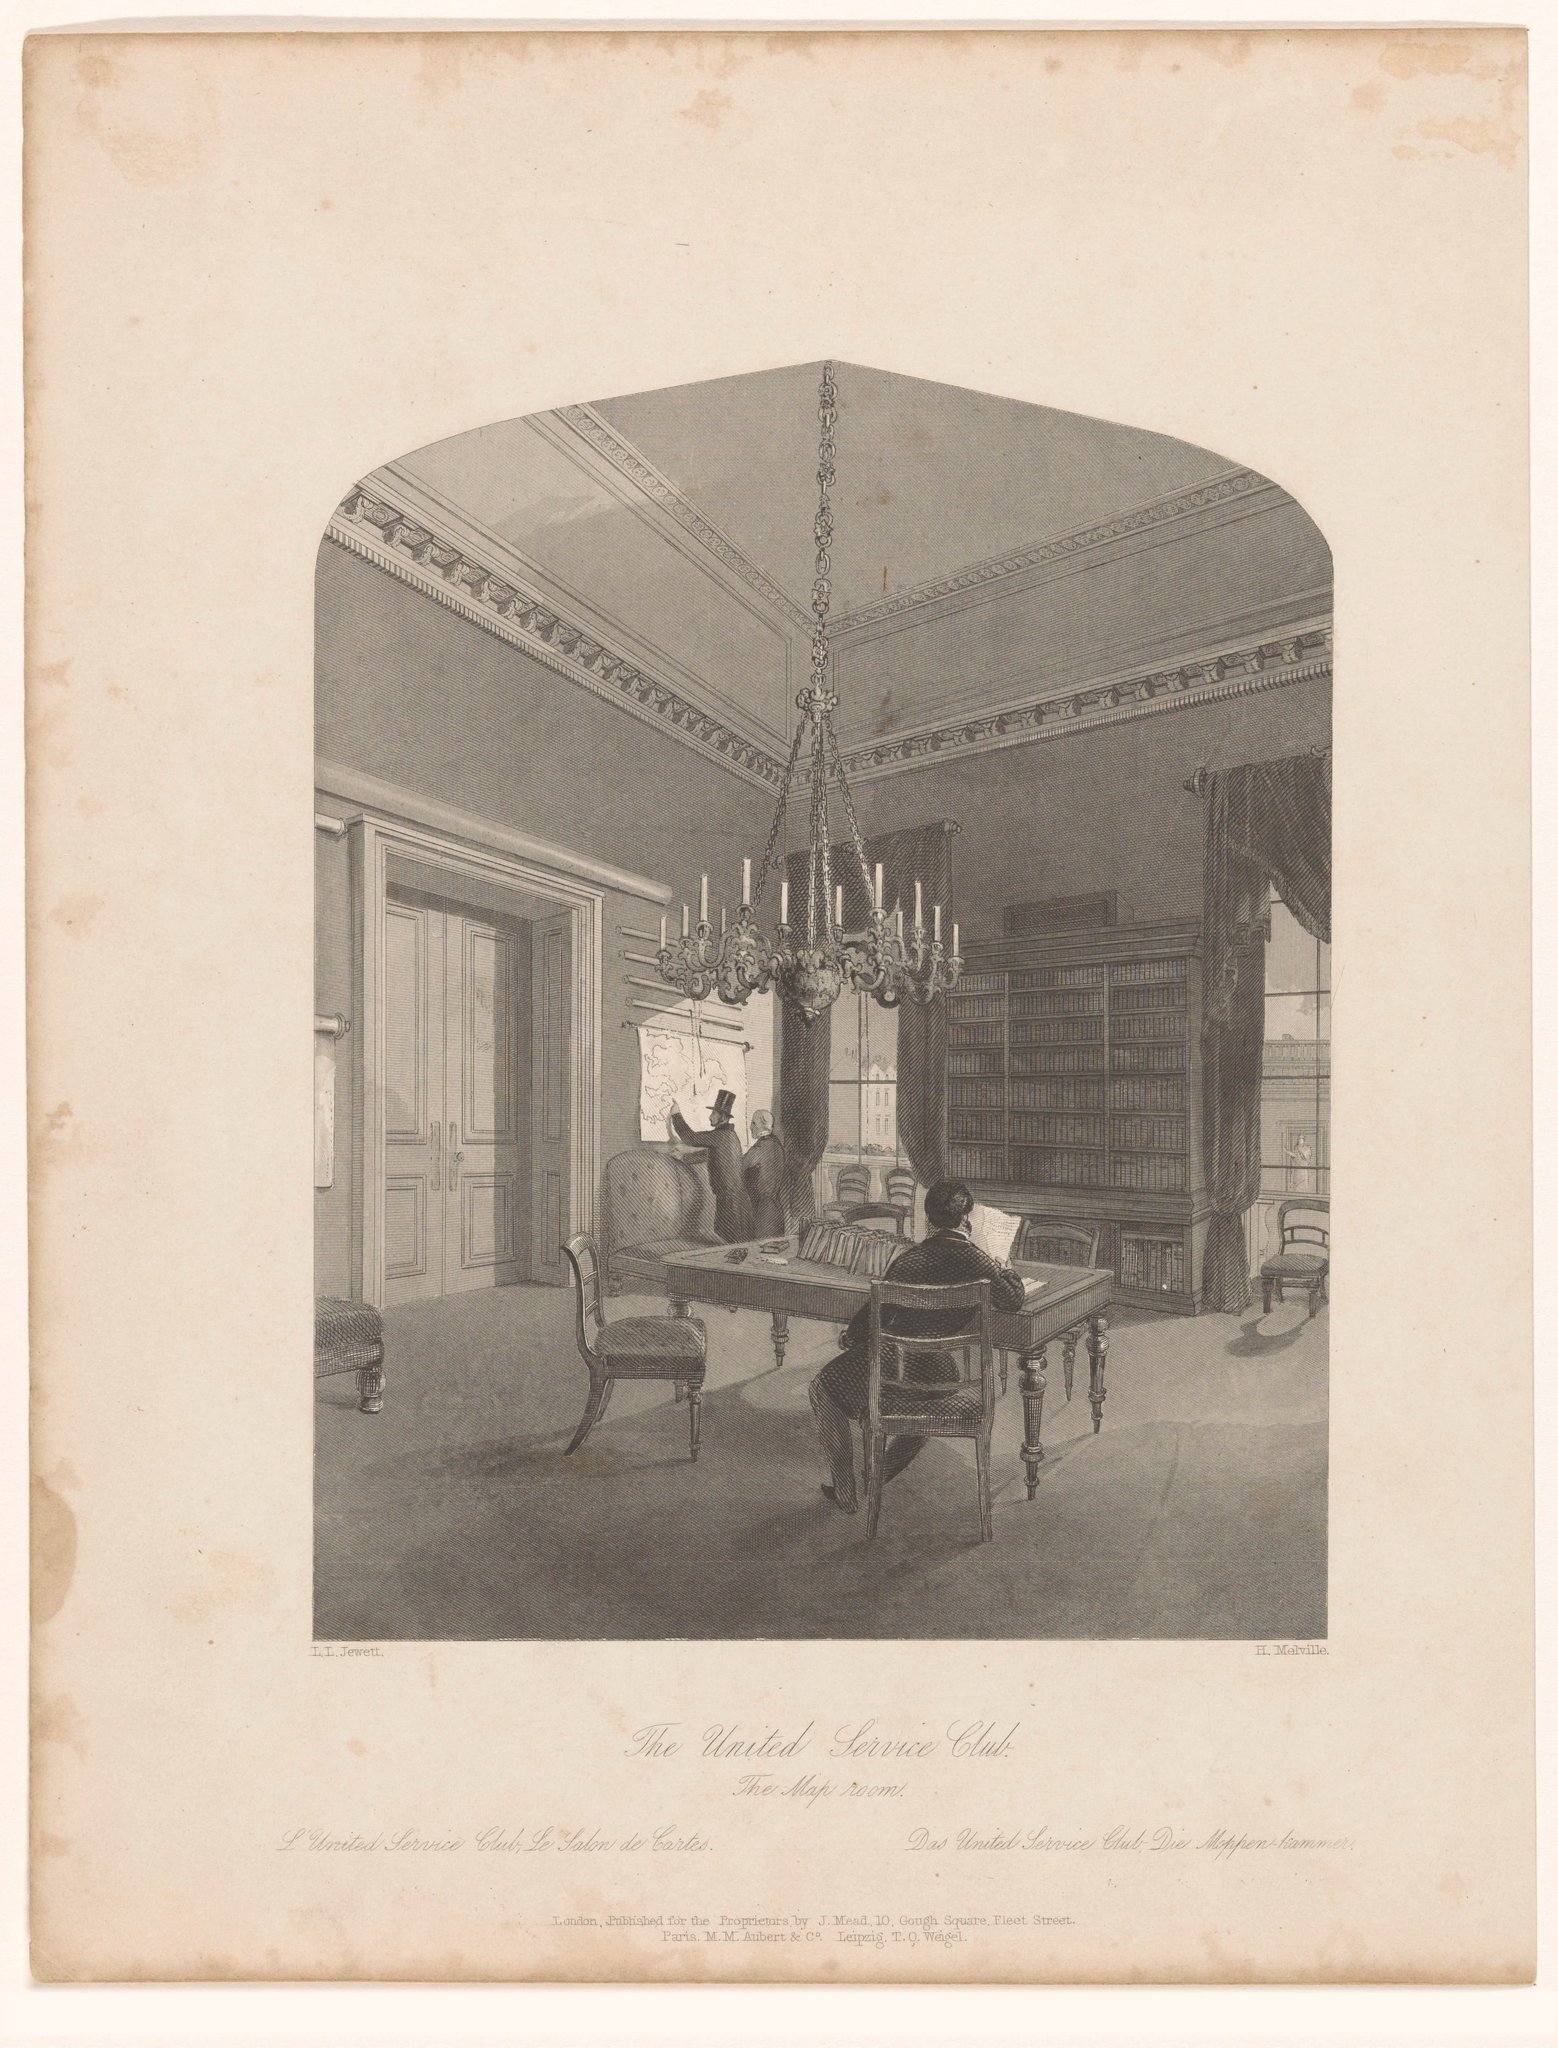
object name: print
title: The United Service Club. The Map room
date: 1841-1844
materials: paper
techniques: engraving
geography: london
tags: learned society, academy of sciences, bookshelves, chandelier, candelabrum, public library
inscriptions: collector's mark: Lugt 4779, collector's mark: Lugt 2228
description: Onder een kroonluchter in het midden van de kamer een leestafel waarachter een man zit te lezen. Twee mannen bekijken een wandkaart, tegen een muur tussen twee ramen staat een boekenkast. Getiteld in het Engels, Frans en Duits.